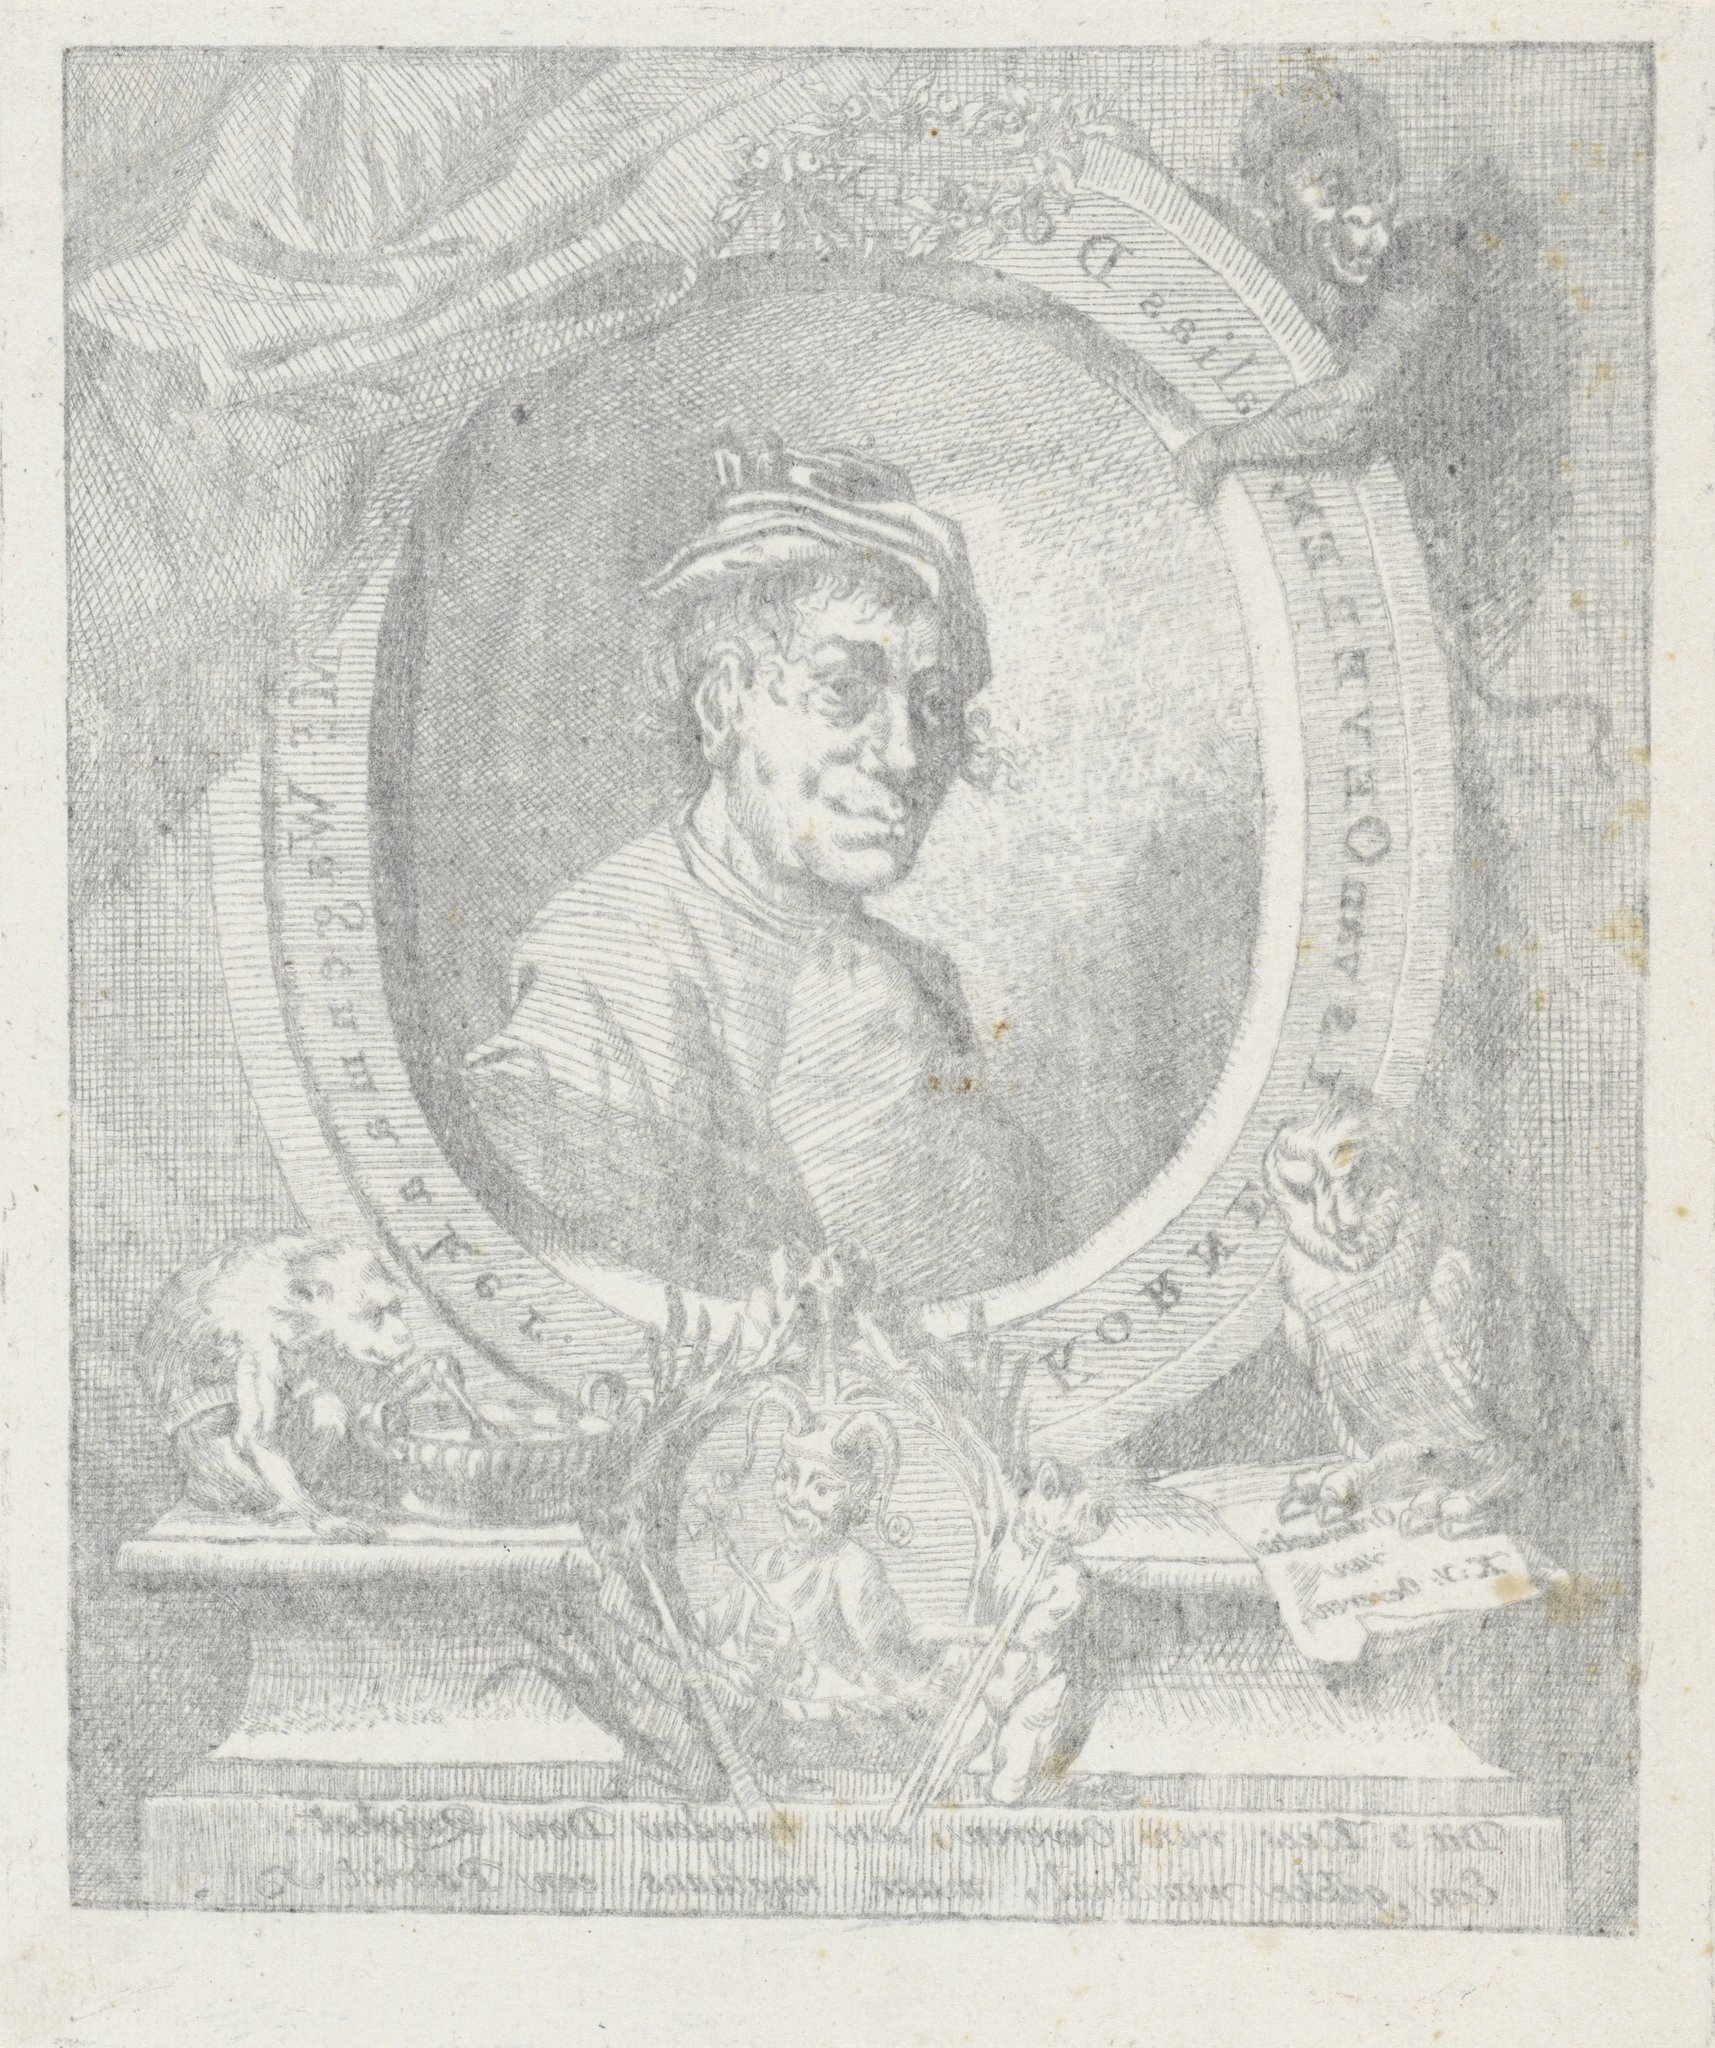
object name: print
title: Contre-épreuve van portret van Kees van Oeveren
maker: jan stolker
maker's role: draughtsman, painter, print maker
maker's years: 1724-1785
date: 1734-1785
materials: paper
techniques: printmaking, etching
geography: netherlands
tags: monkeys, apes, fool's cap, political caricatures and satires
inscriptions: collector's mark: Lugt 240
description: Karikaturaal portret van Cornelis van Oeveren, wagenmaker en leider van de prinsgezinden te Rotterdam. Een aap klemt zich vast aan de lijst en kroont het portret met een krans van oranjetakken. Op het basement een uil en een aap bij een kom met pap. Midden onder een nar met zotskap.